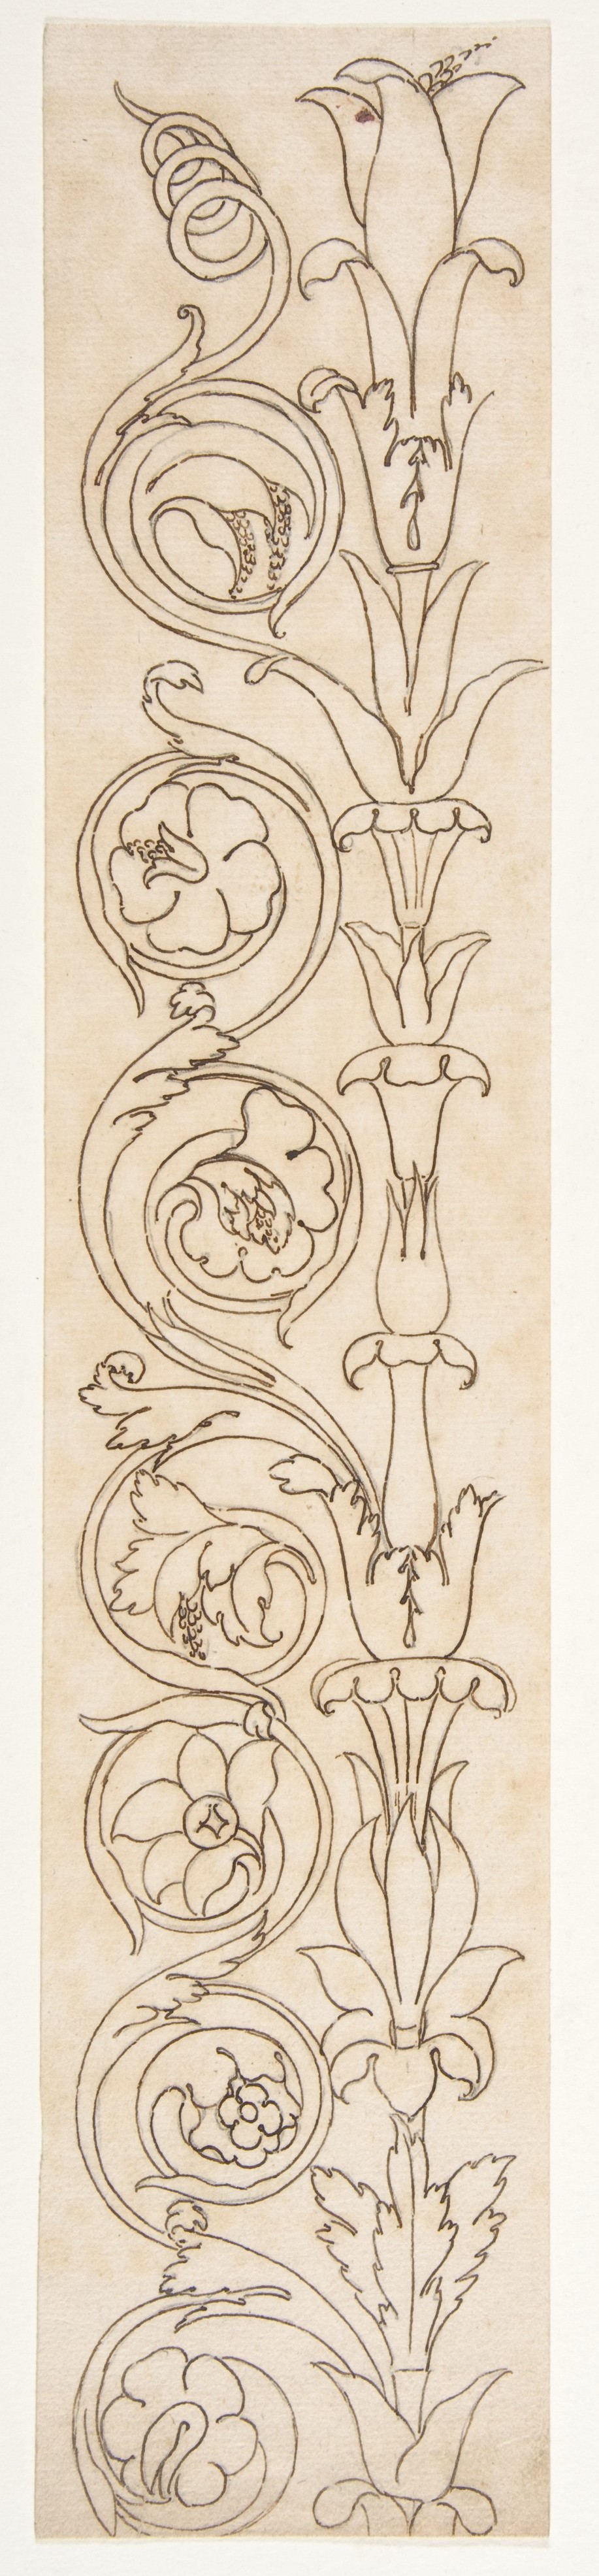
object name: collection ornament architecture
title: Ornamental drawings (recto) blank (verso)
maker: anonymous, french, 16th century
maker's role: draftsman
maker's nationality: french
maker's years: 1500-1600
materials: chalk, ink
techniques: incising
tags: ornament